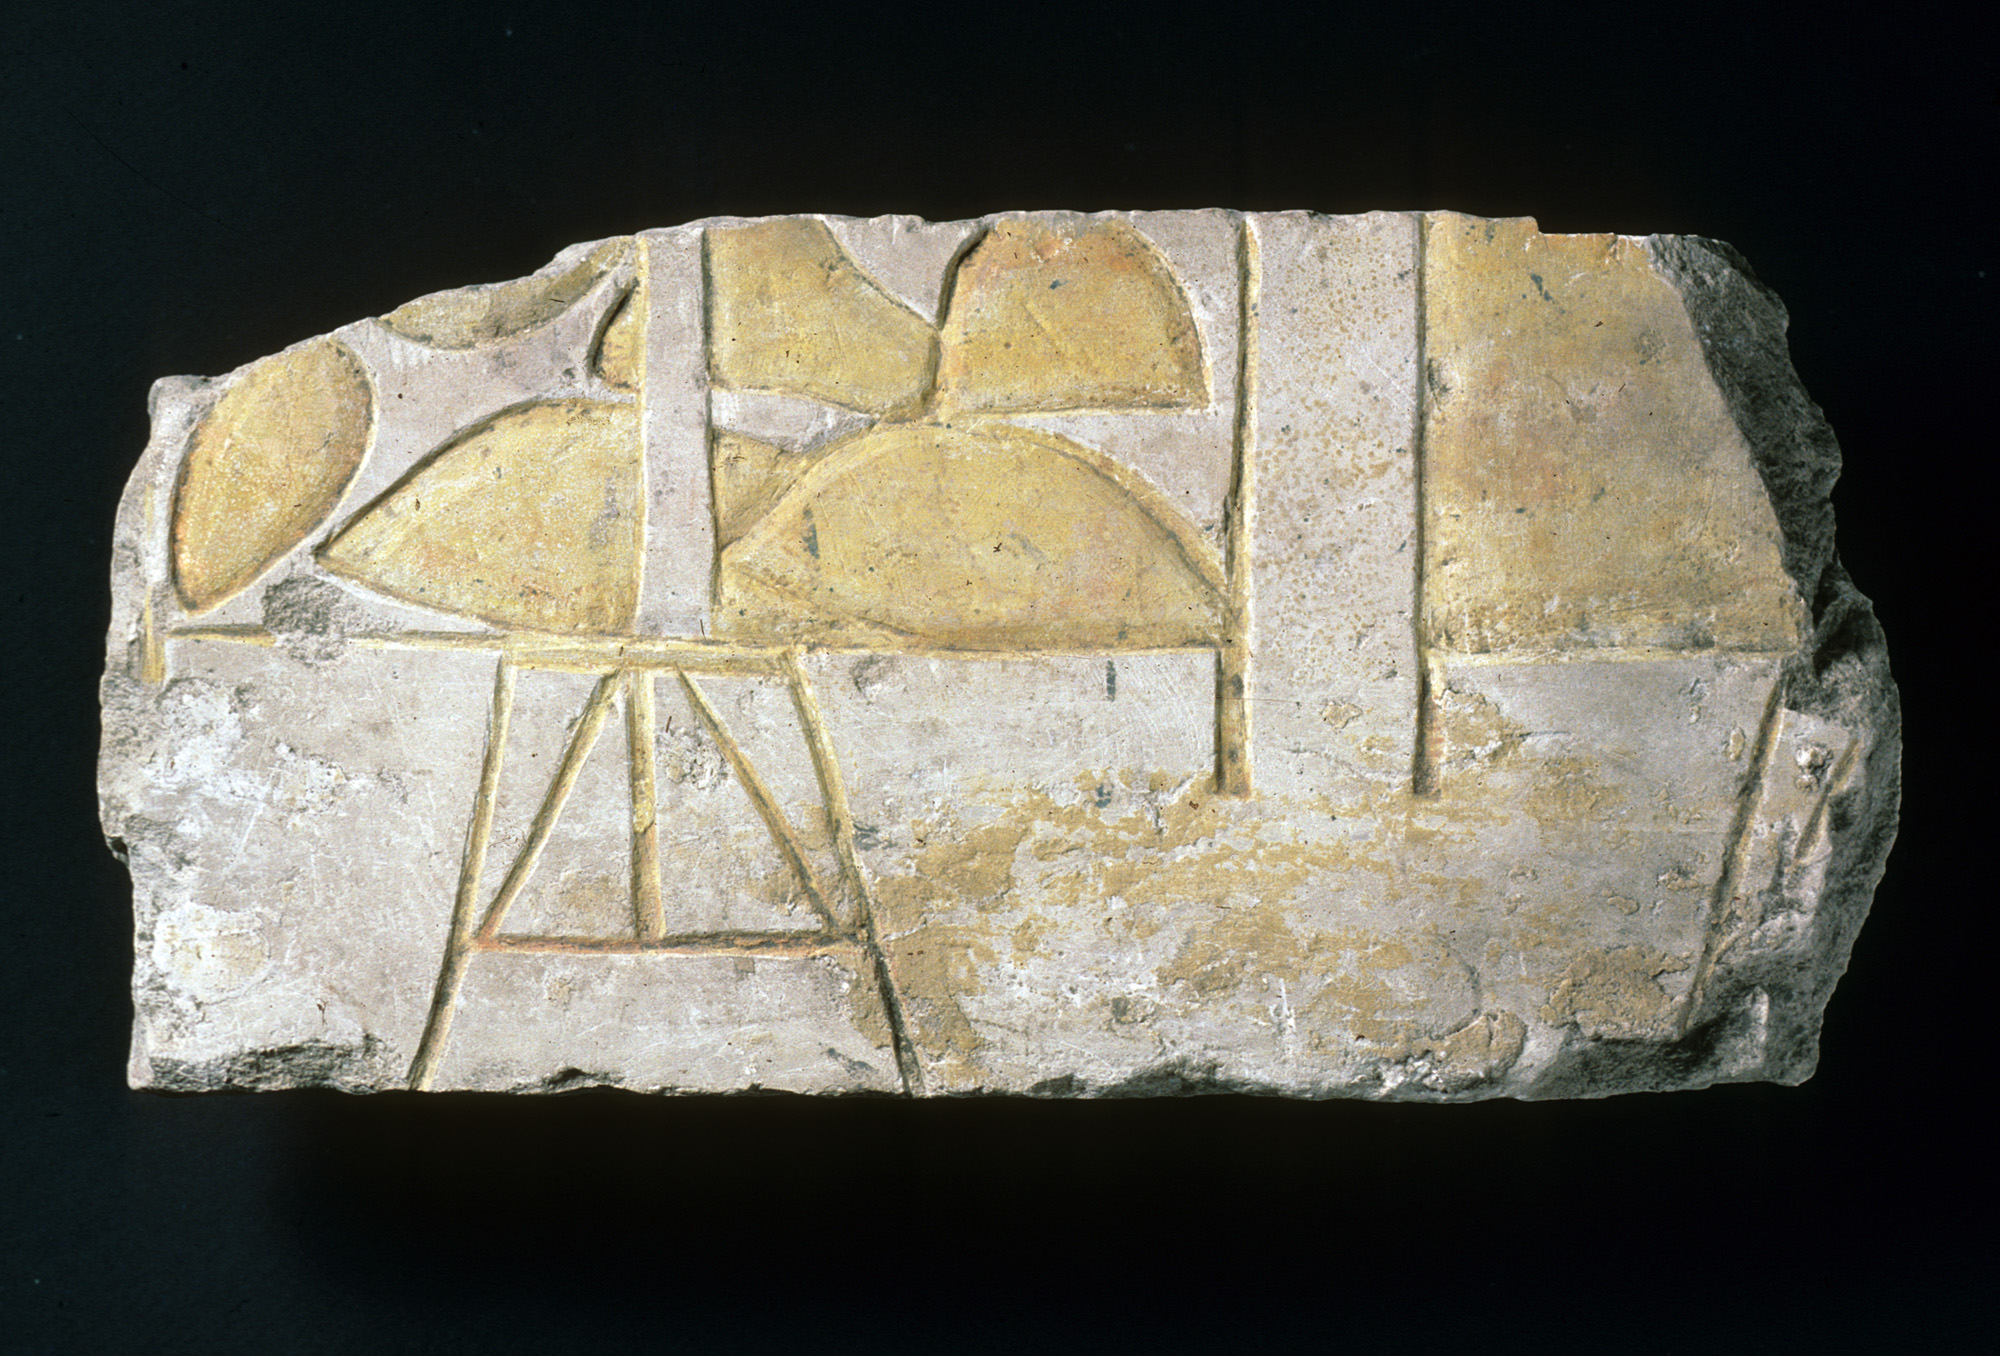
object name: talatat, laden stand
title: Relief with laden stand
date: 1353-1336 BCE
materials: limestone, paint